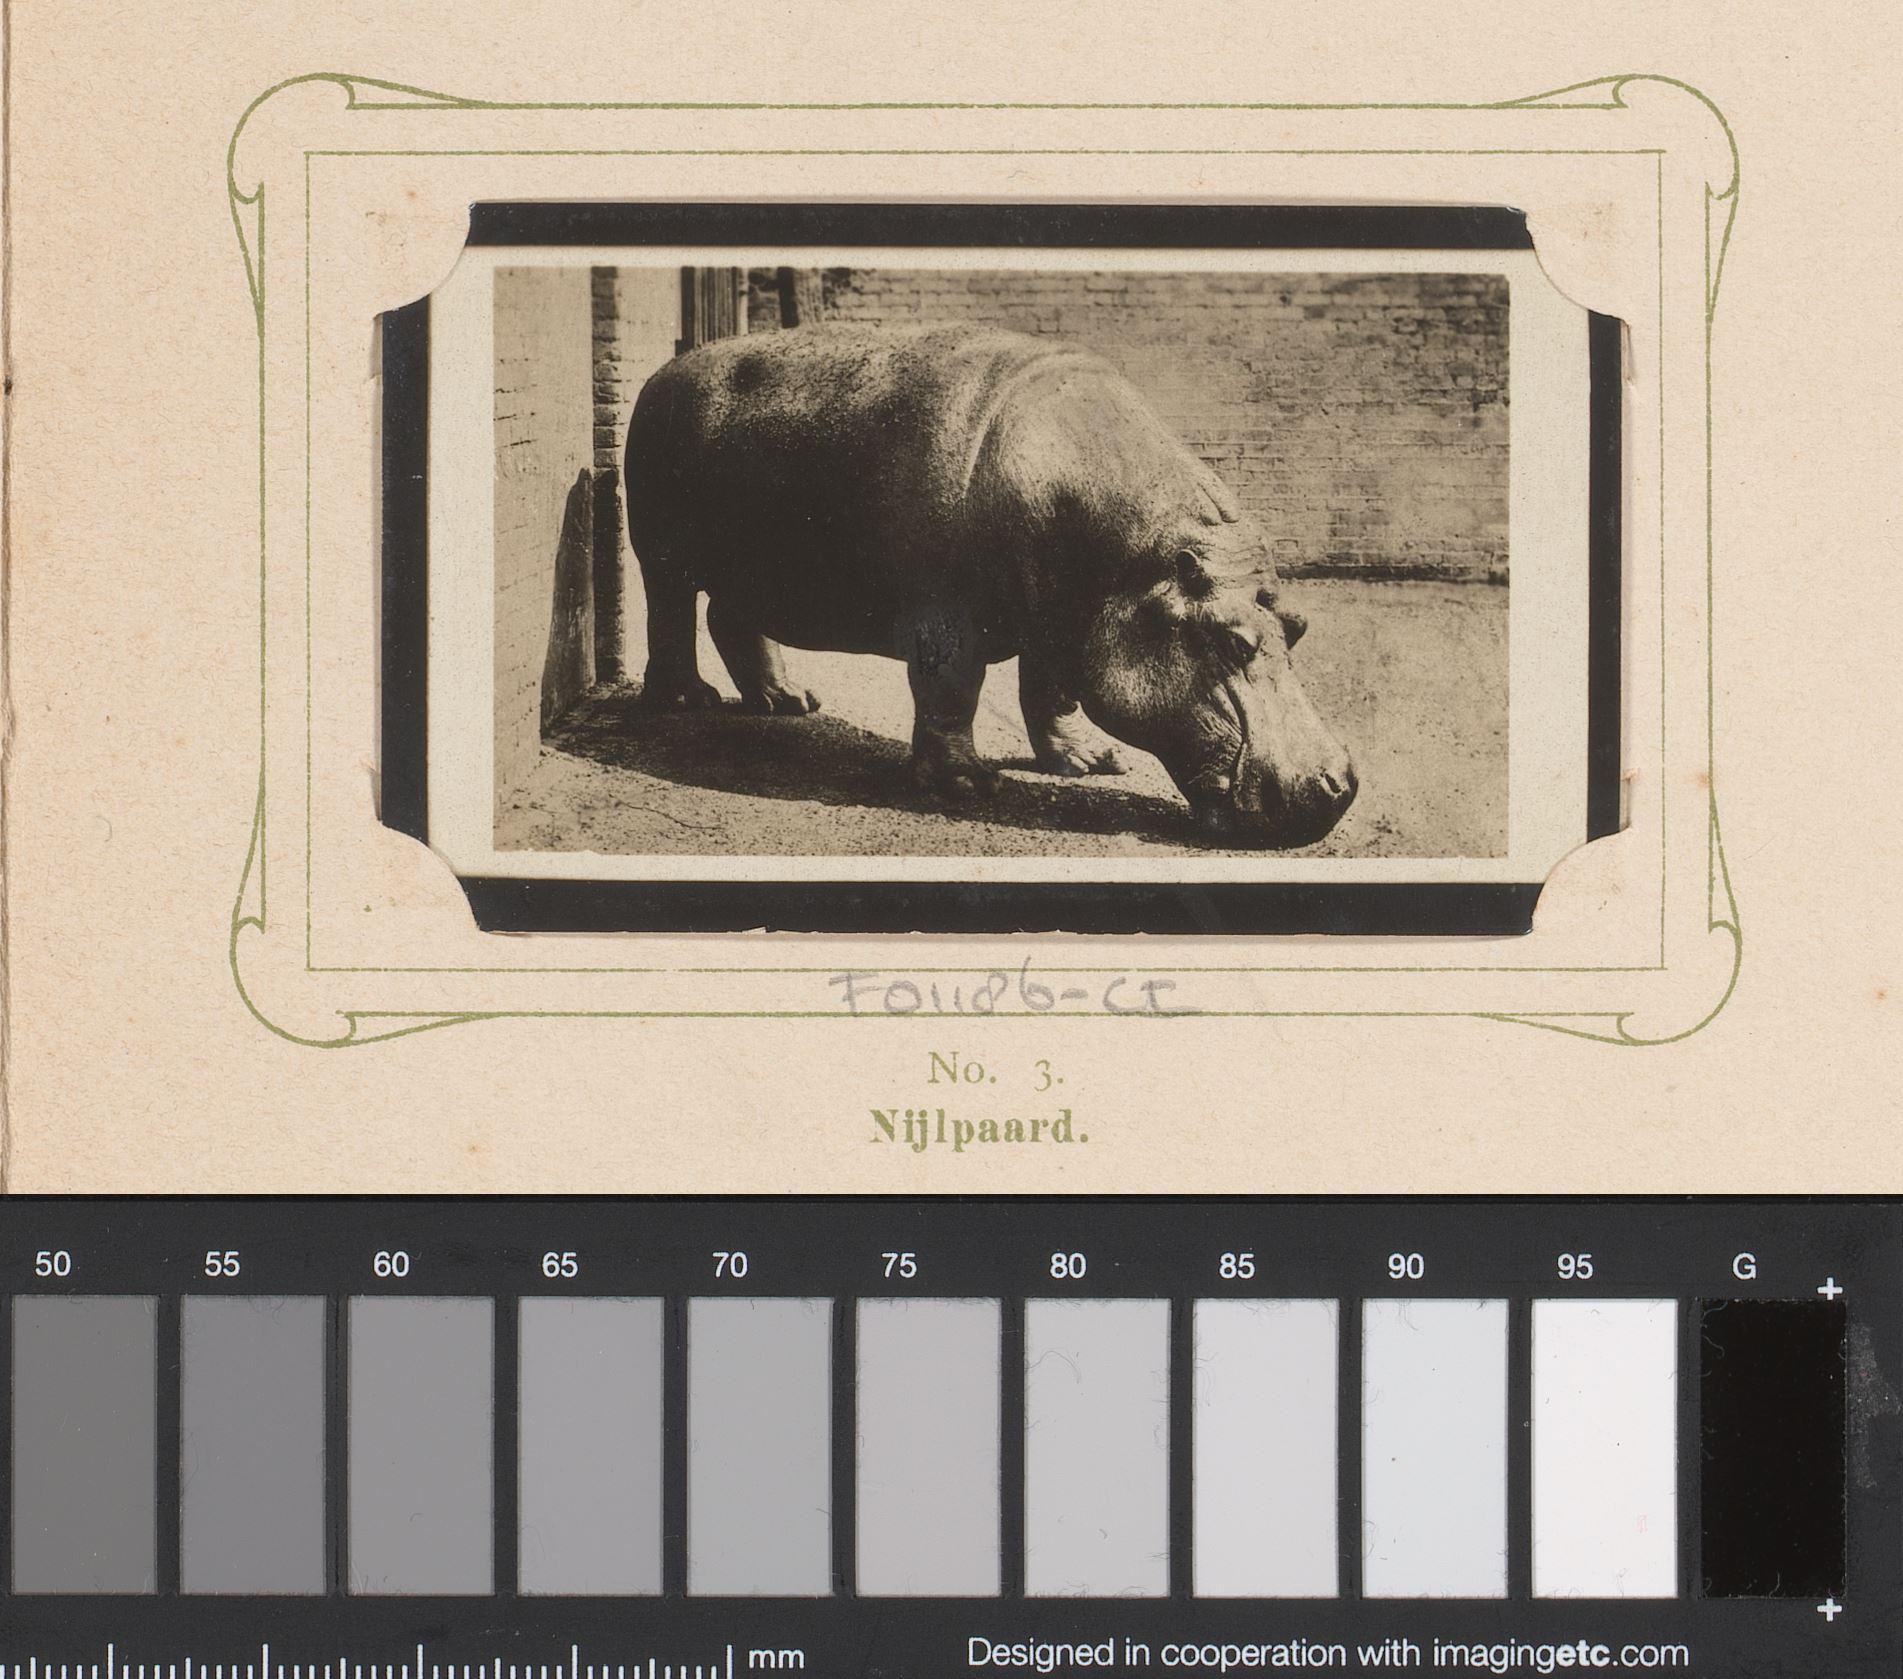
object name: photograph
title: Nijlpaard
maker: Anonymous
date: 1904-1905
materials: photographic support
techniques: gelatin silver print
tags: hoofed animals: hippopotamus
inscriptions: inscription: ‘No. 3./ Nijlpaard.’